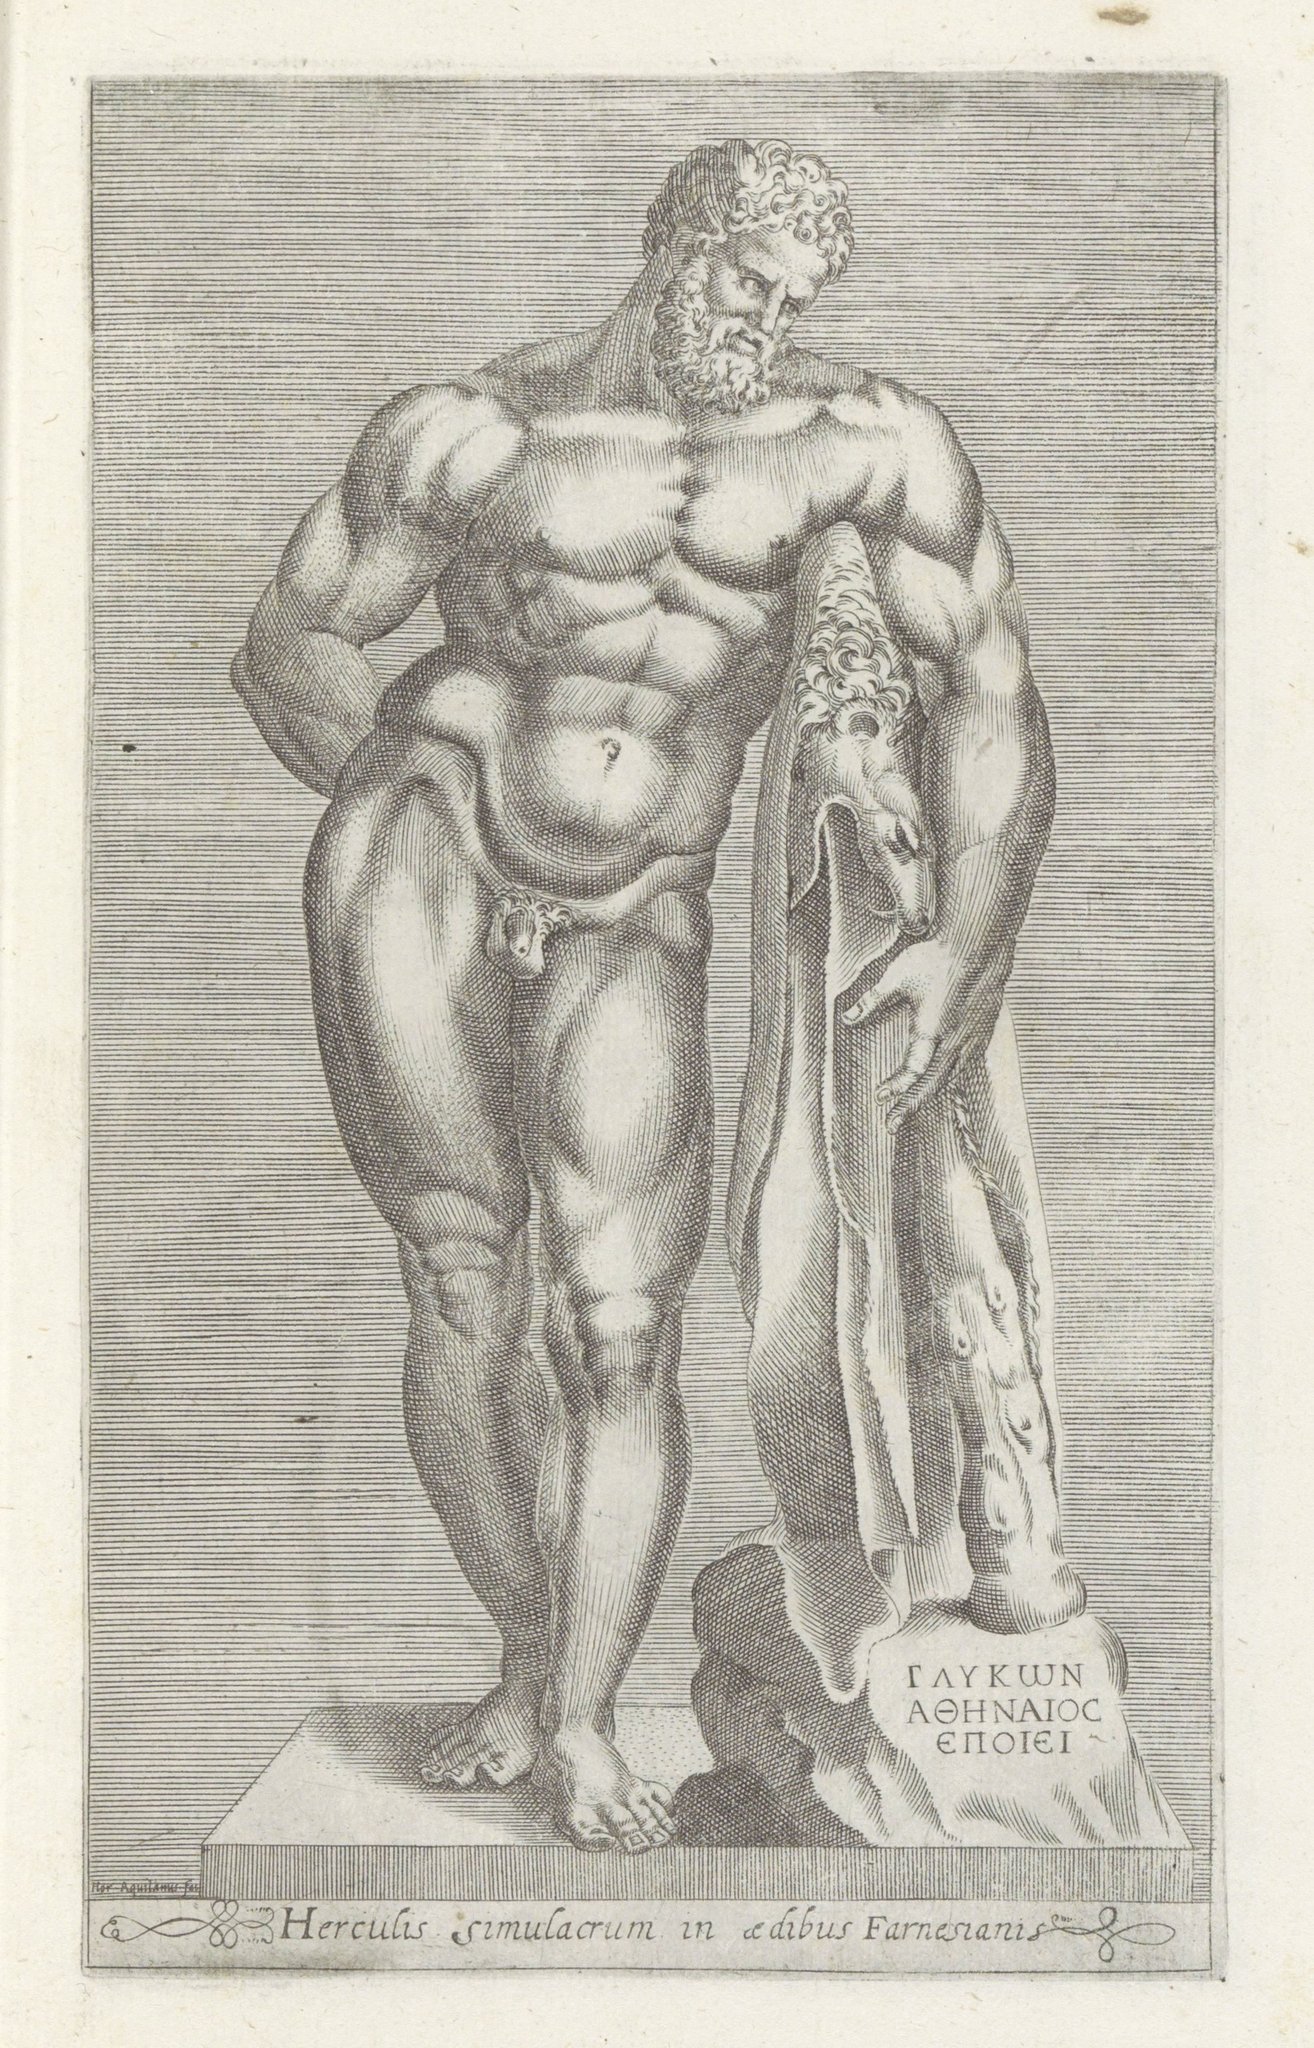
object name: album leaf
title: Hercules Farnese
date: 1584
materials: paper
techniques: engraving, intaglio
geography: rome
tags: (story of) hercules (heracles), piece of sculpture, reproduction of a piece of sculpture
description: Tot 1787 stond dit beeld in het Palazzo Farnese, vandaar de benaming Hercules Farnese. Deze prent maakt deel uit van een set van 79 prenten (+ titelprent) met voorstellingen van antieke sculpturen in Rome. Deze prent maakt deel uit van een set van 79 prenten (+ titelprent) met voorstellingen van antieke sculpturen in Rome.